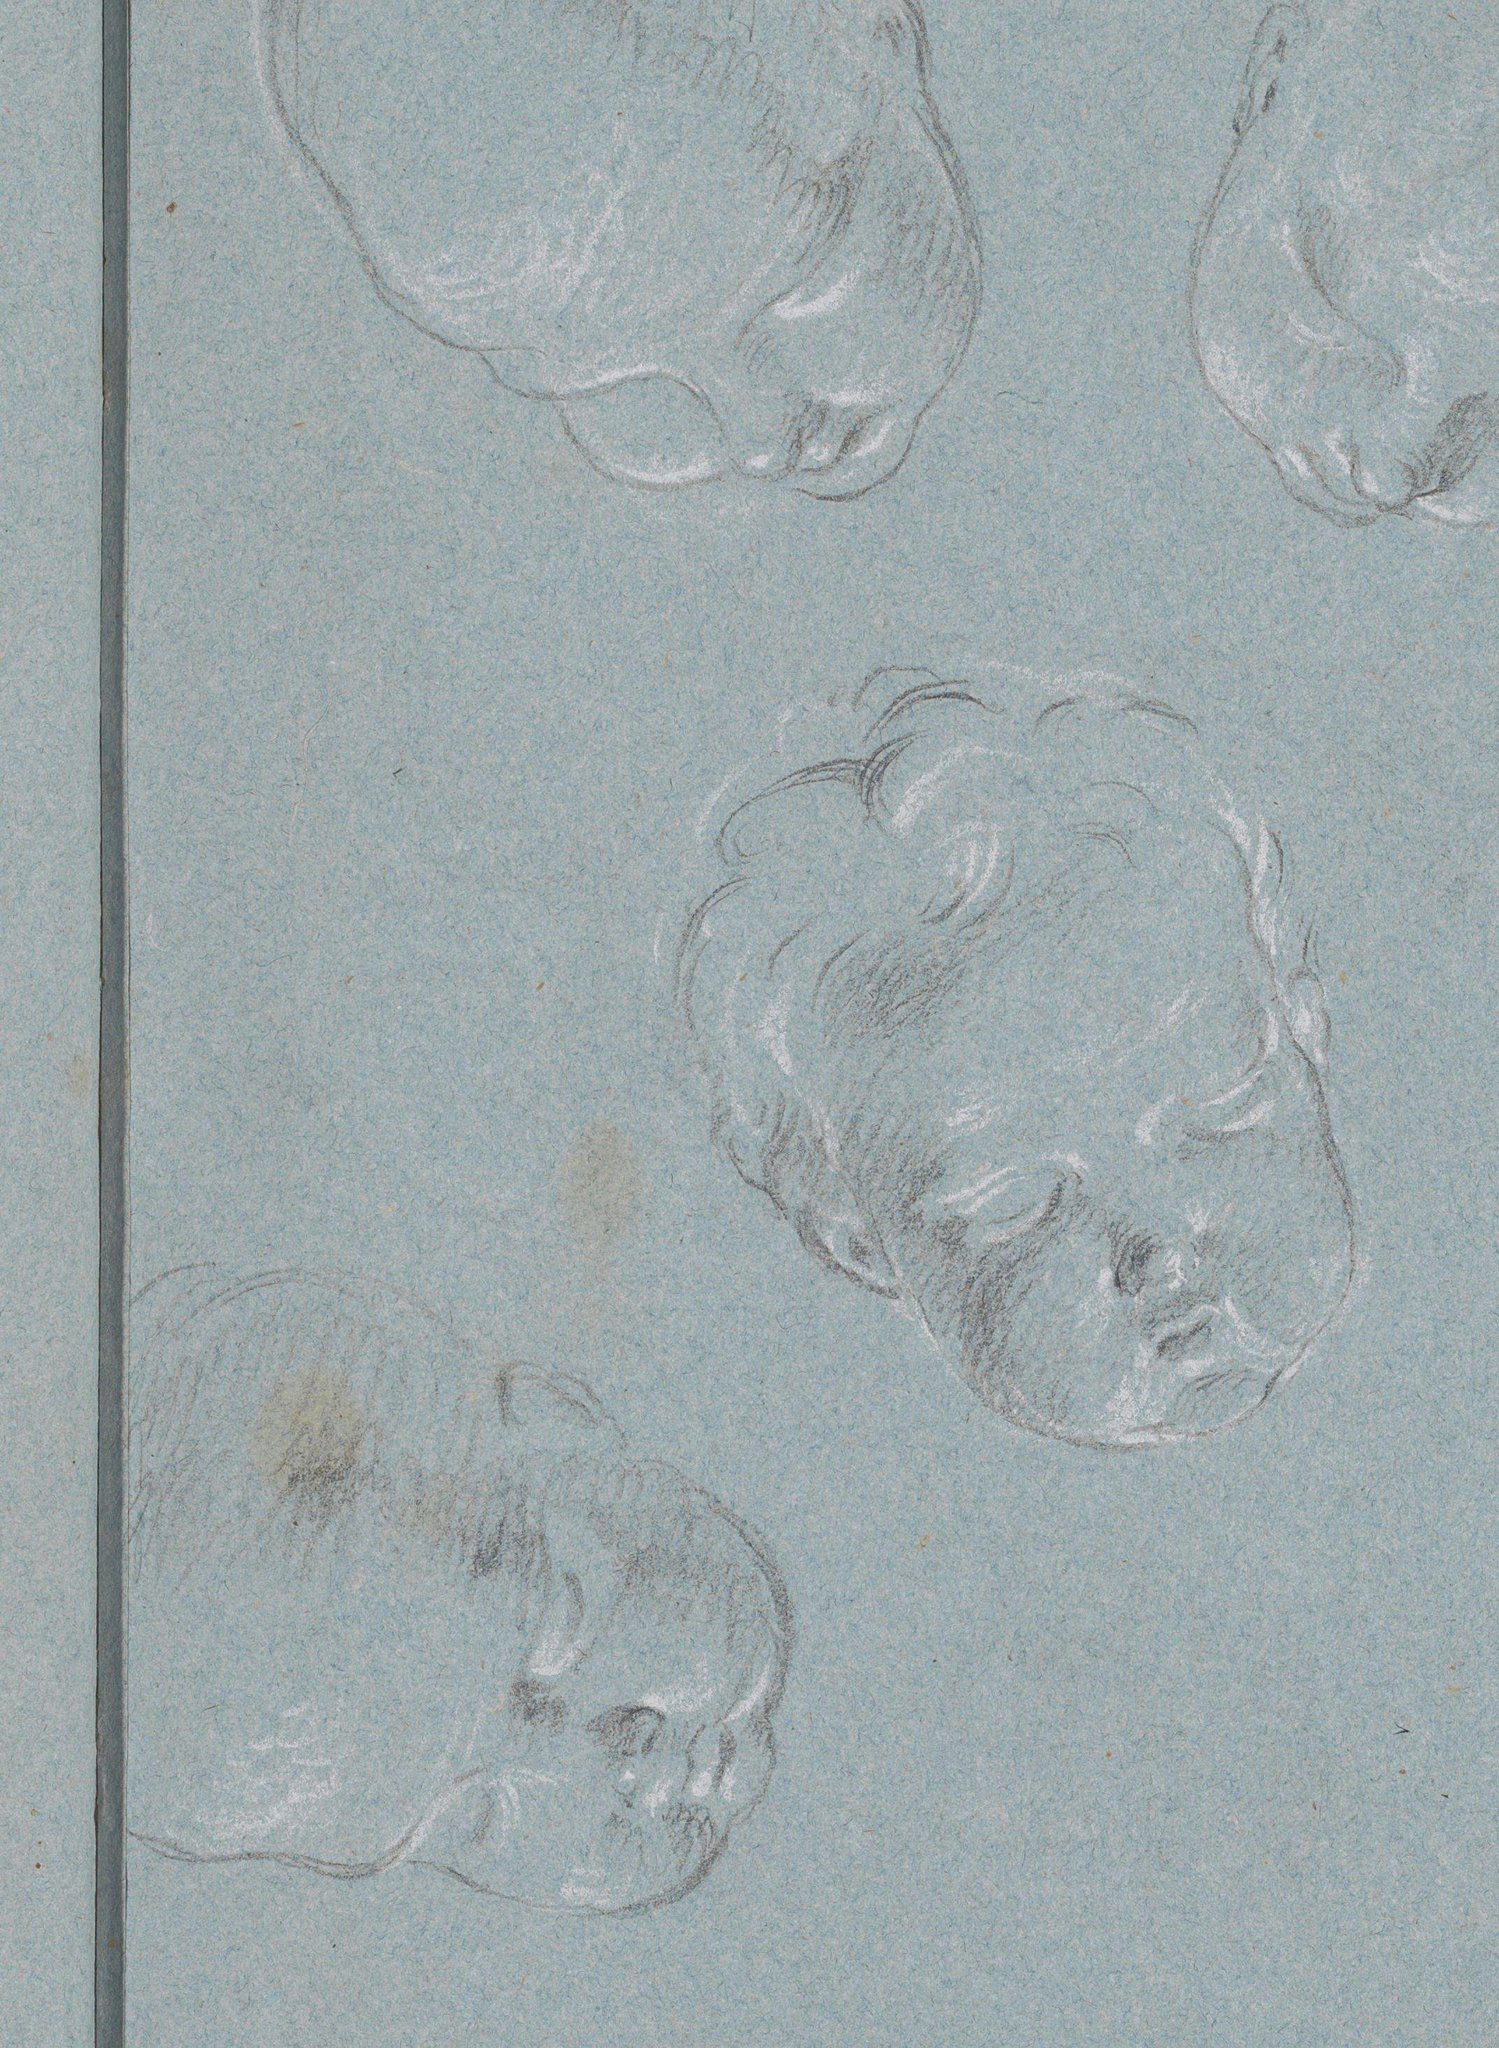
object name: sketchbook leaf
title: Vier koppen van putti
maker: lorenzo baldissera tiepolo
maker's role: draughtsman, print maker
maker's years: 1736-1776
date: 1751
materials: chalk, paper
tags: head (human), cupids: 'amores', 'amoretti', 'putti'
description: Bladzijde 61 uit een schetsboek met 158 bladzijden.